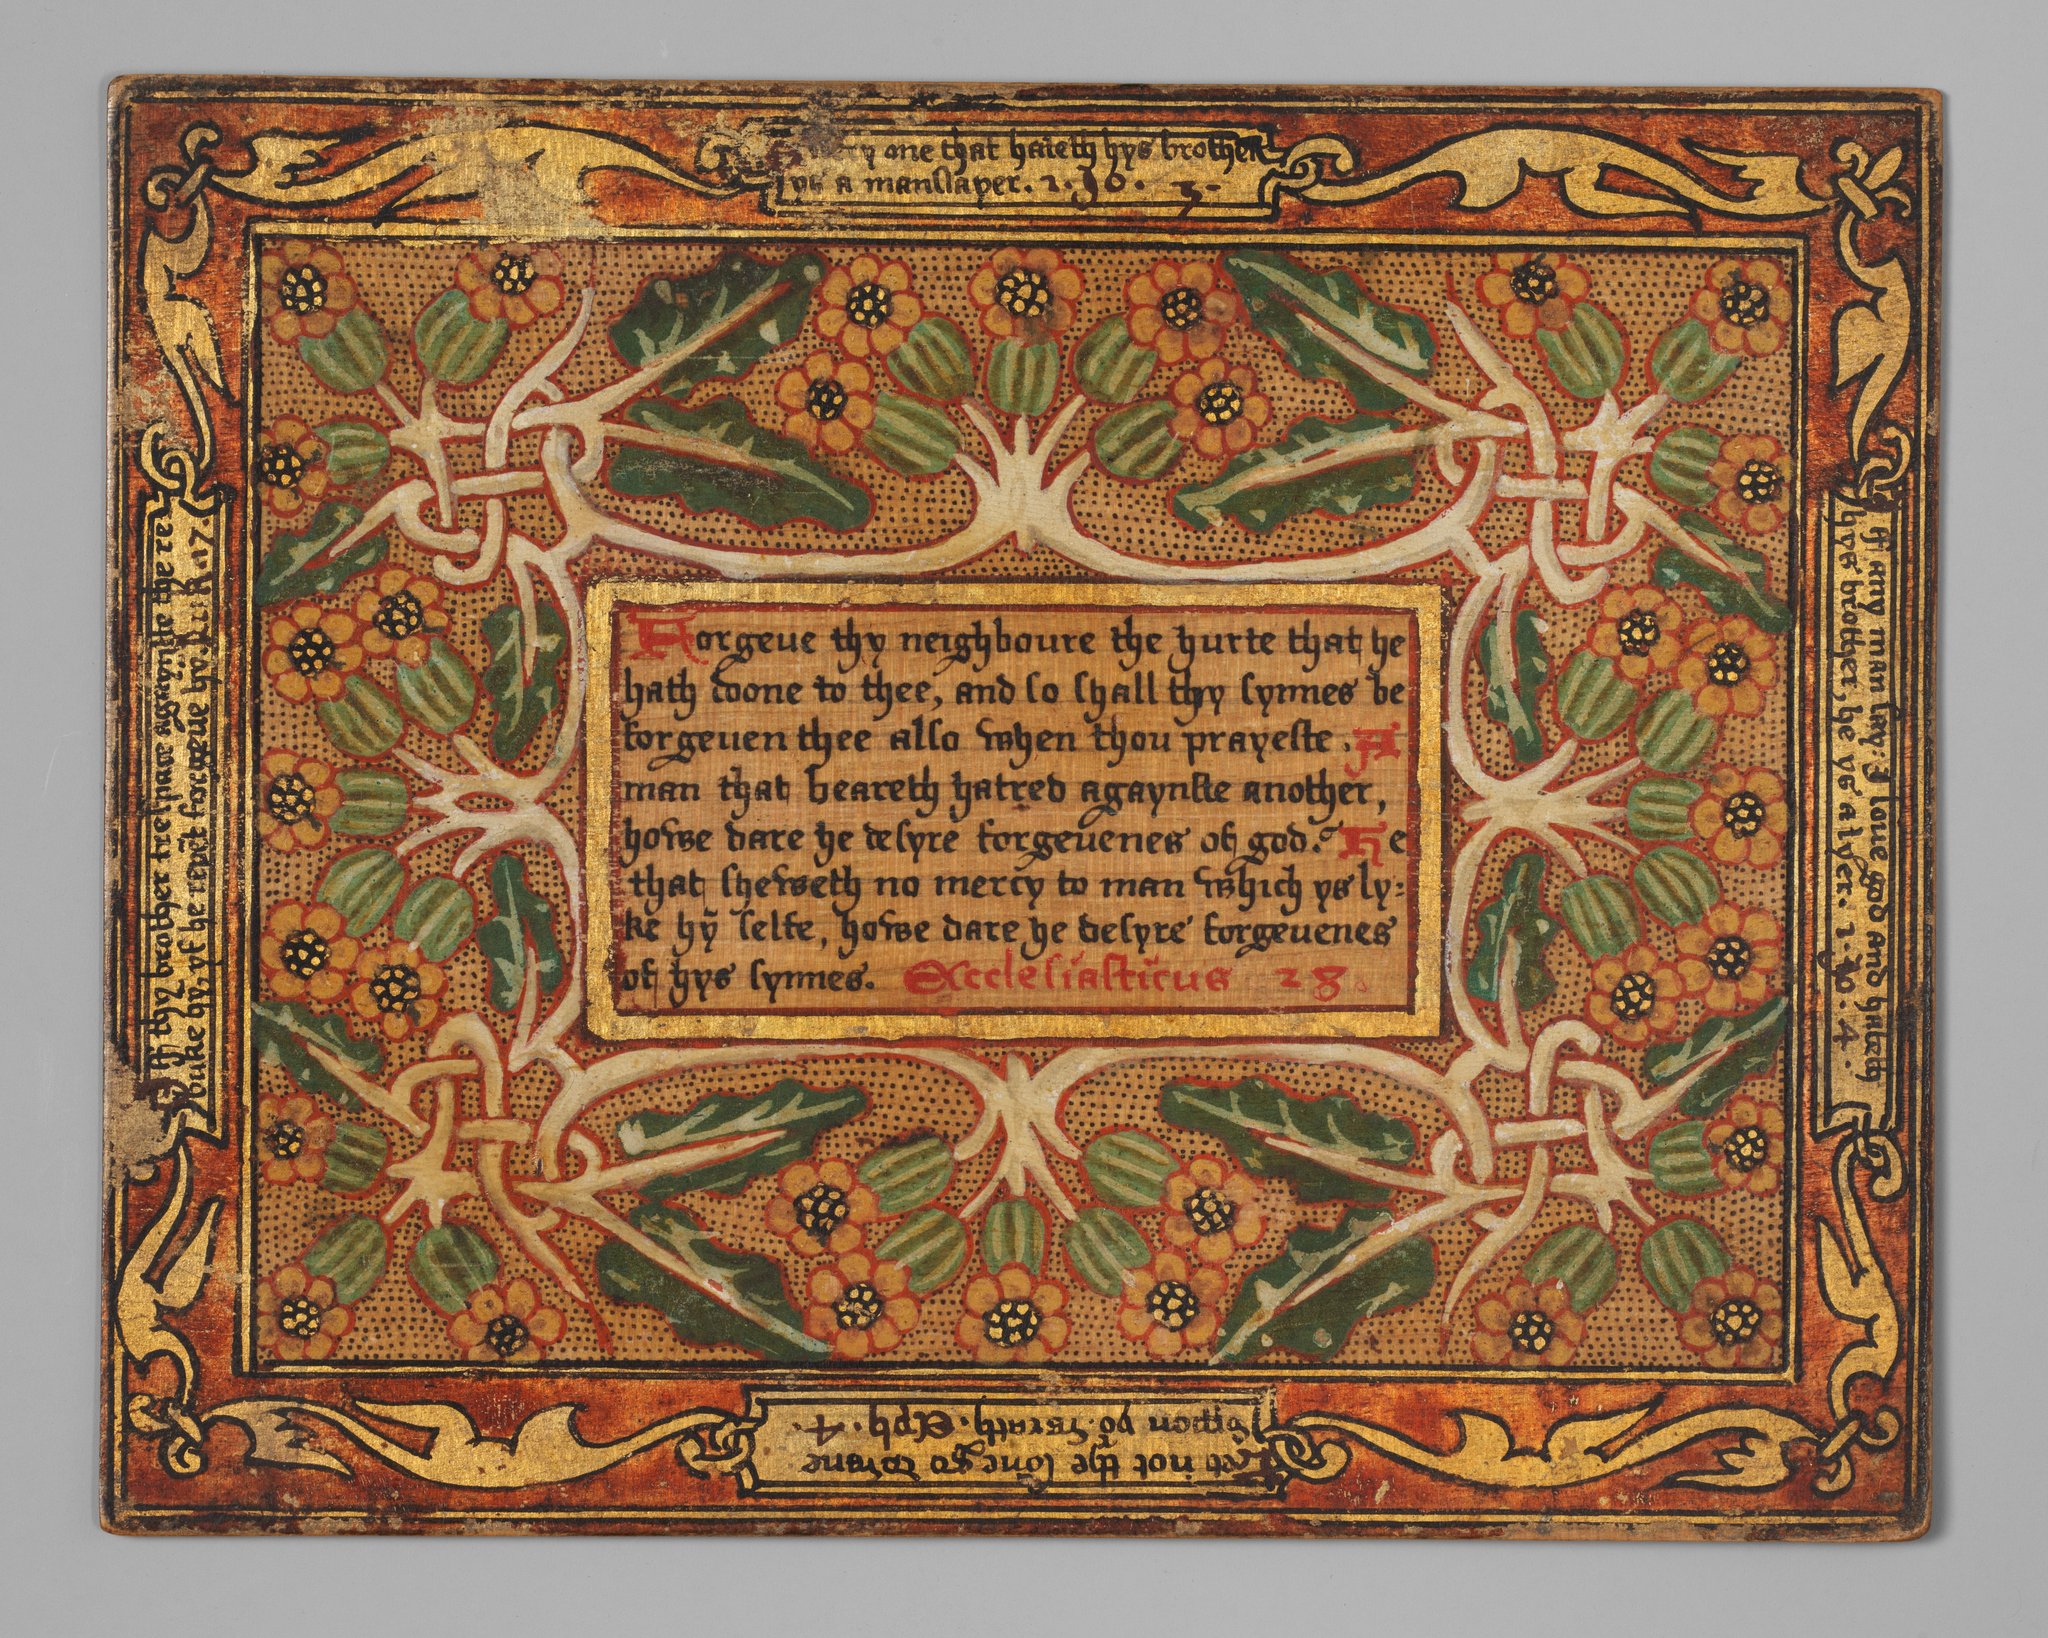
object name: trencher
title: Trencher with quotation from The Governance of Virtue (1566) (one of a set)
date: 1601-1633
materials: wood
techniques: gilding, painting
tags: flowers